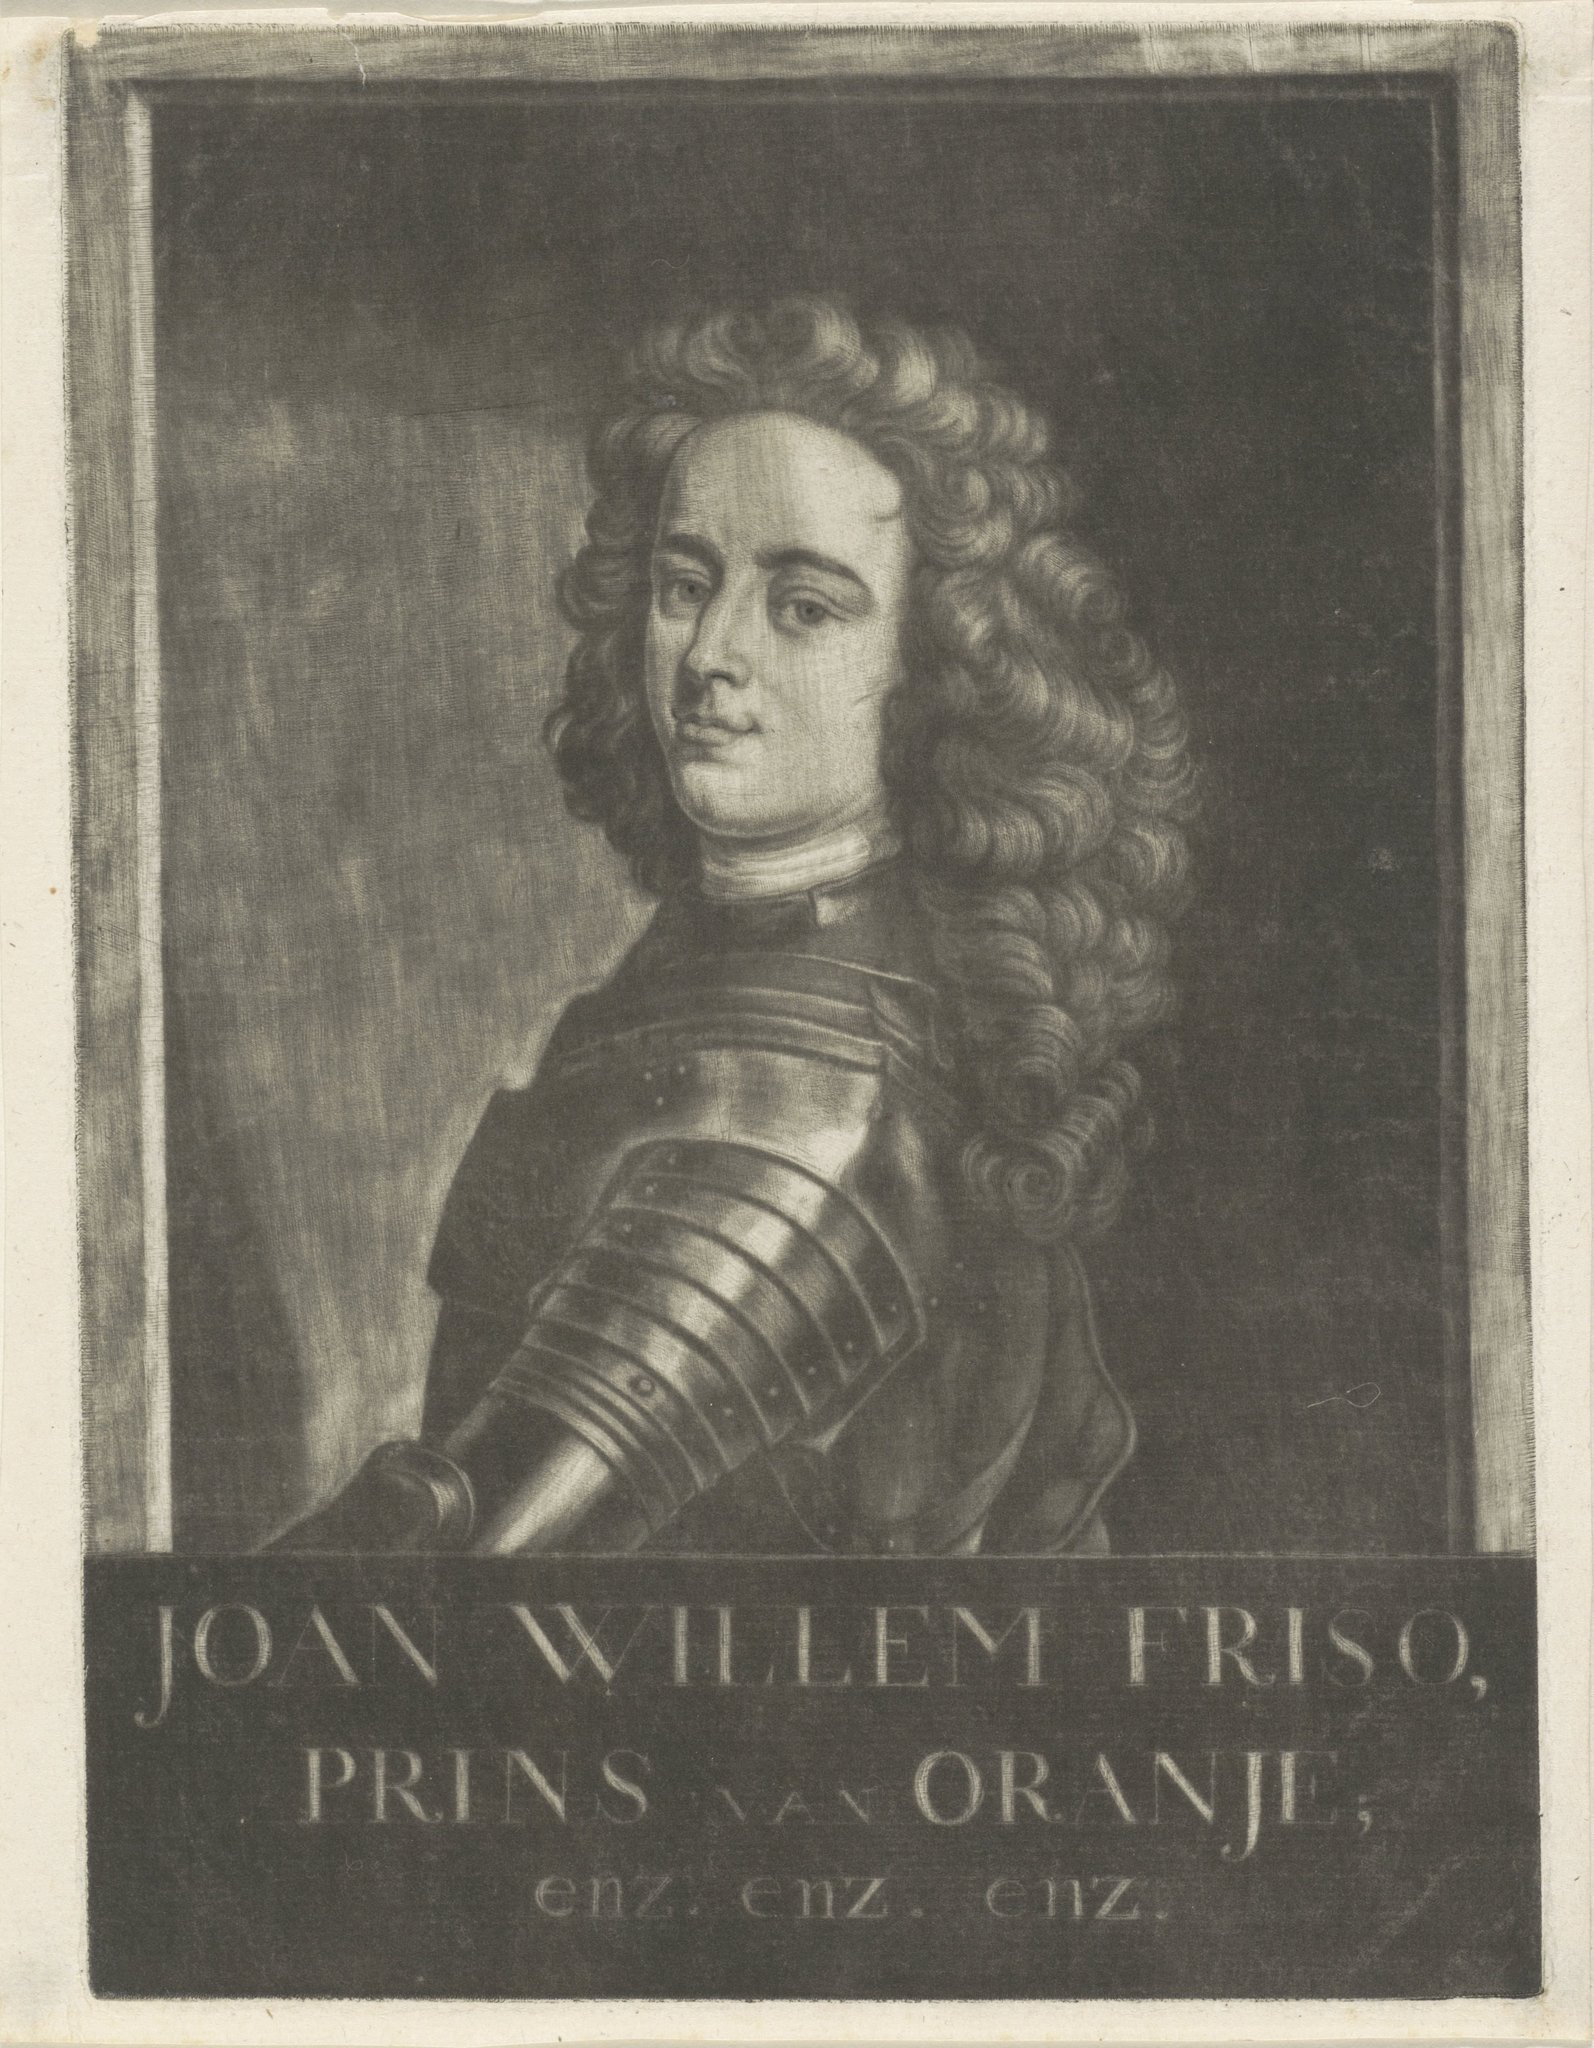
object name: print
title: Portret van Johan Willem Friso, prins van Oranje-Nassau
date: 1770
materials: paper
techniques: mezzotint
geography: northern netherlands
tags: johan willem friso (prins van oranje-nassau)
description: De hier vermelde titel verwijst naar de hoogst verkregen titel van de geportretteerde, niet per se naar de titel die de geportretteerde op deze voorstelling draagt. Prent uit: Bosch, Johannes van den. De heeren stadhouderen van Vriesland, zedert den jare acht-hondert, volgens hoogst derzelver successie kortelyk beschreven. Leeuwarden: Abraham Ferwerda en Gerrit Tresling, 1770.